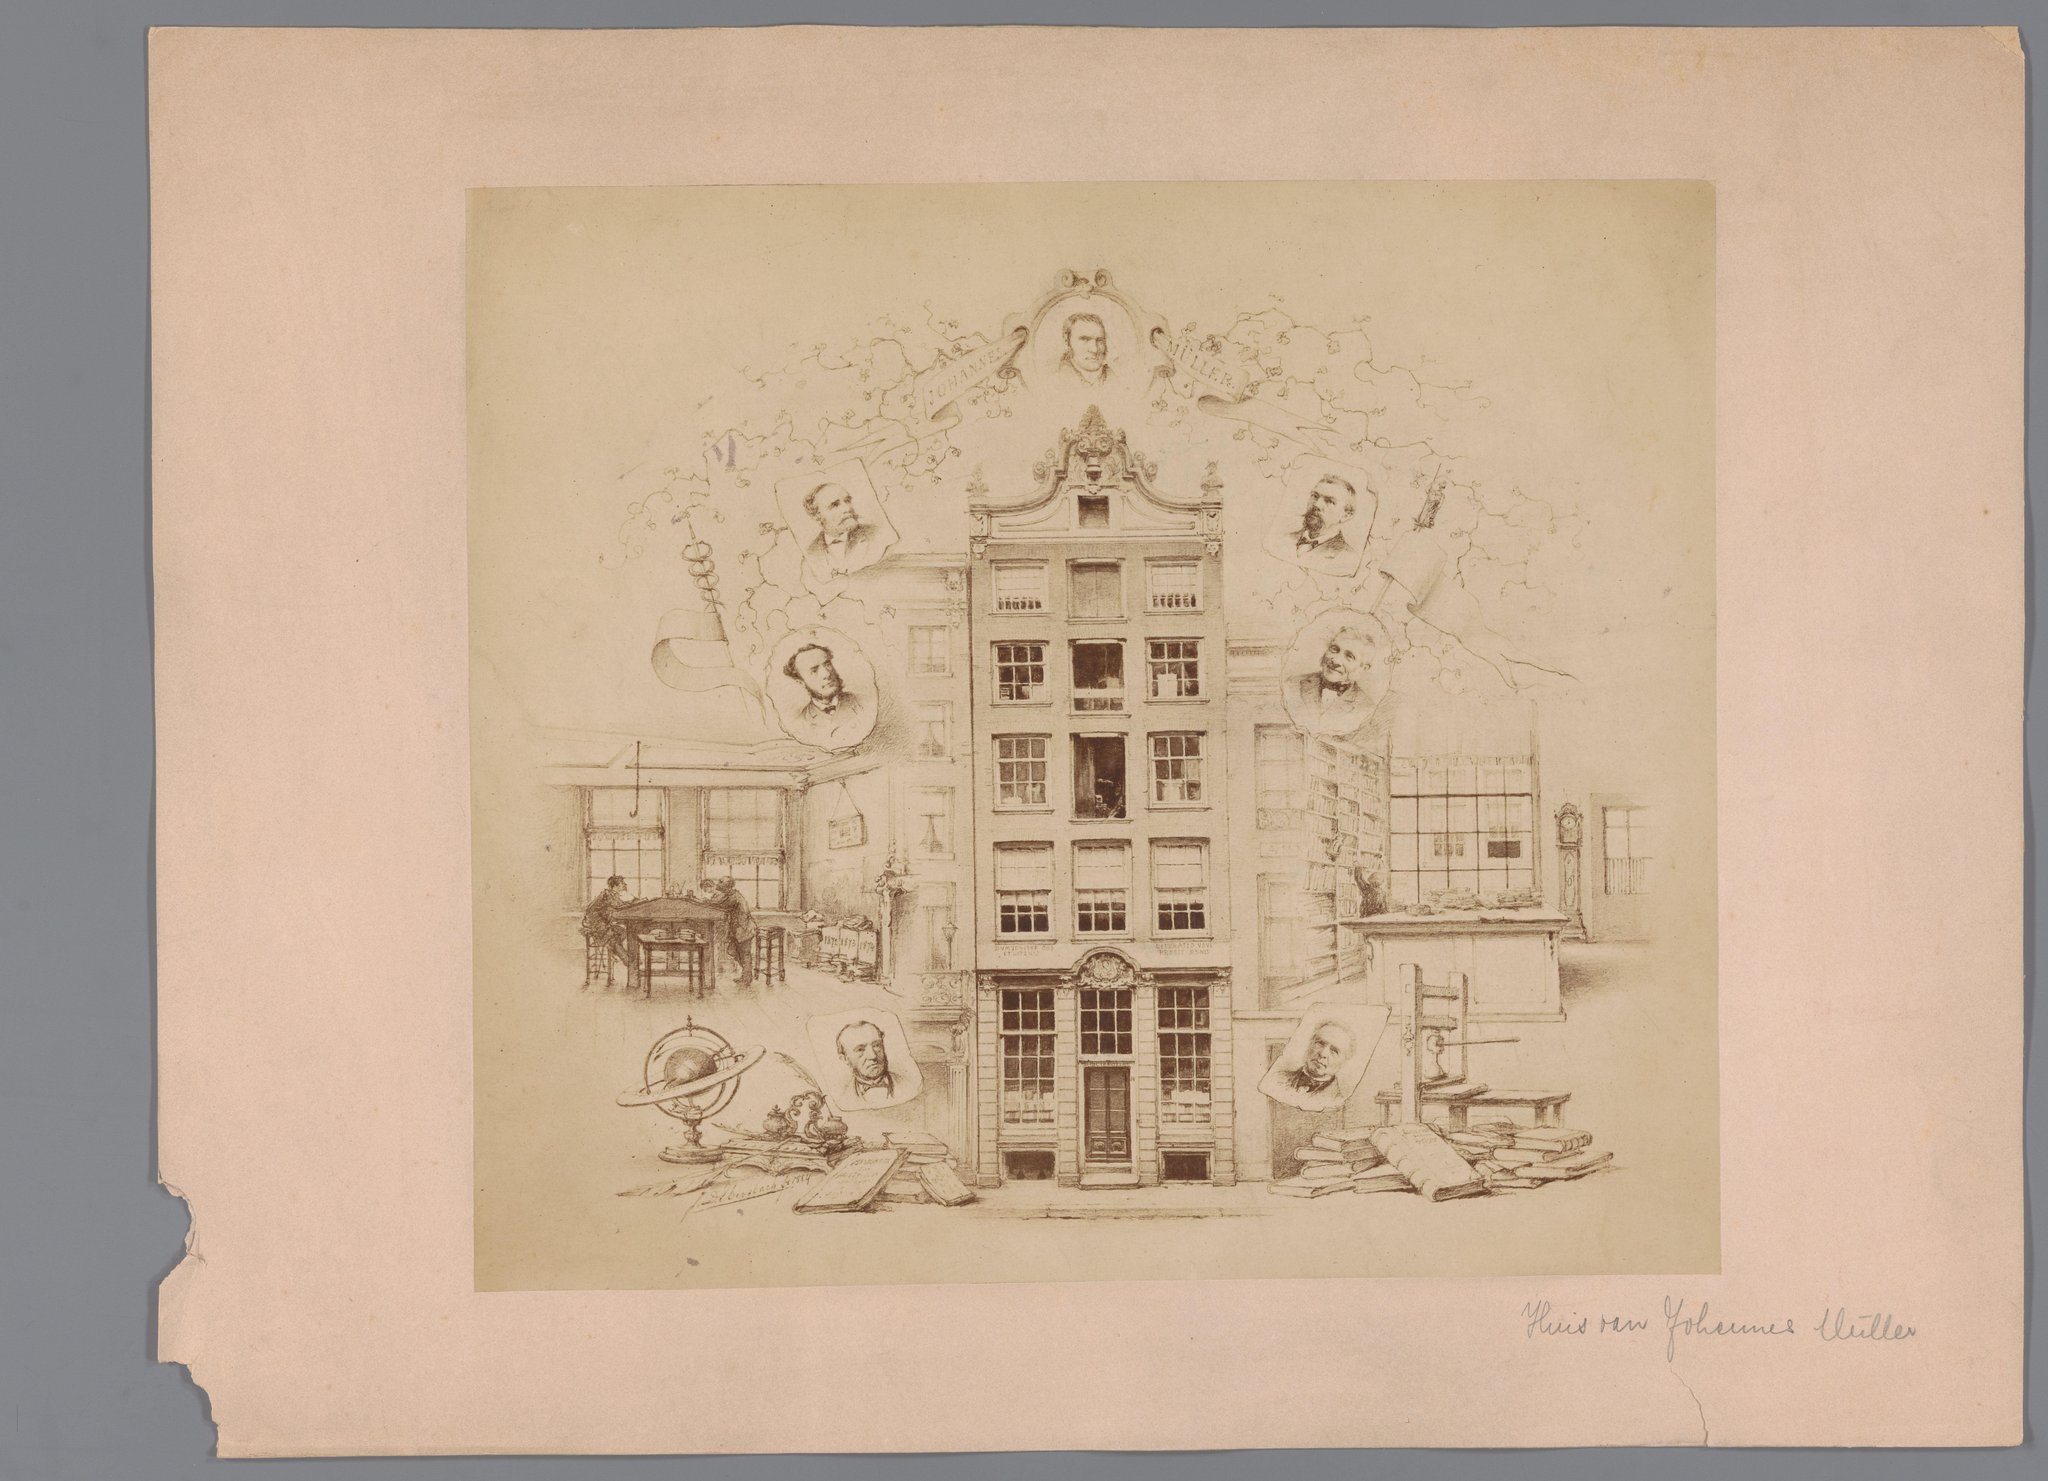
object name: photograph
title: Ingang van het stadhuis te Franeker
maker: Anonymous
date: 1900-1930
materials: photographic support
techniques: gelatin silver print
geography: franeker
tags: townhall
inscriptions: annotation: ‘Franeker?’